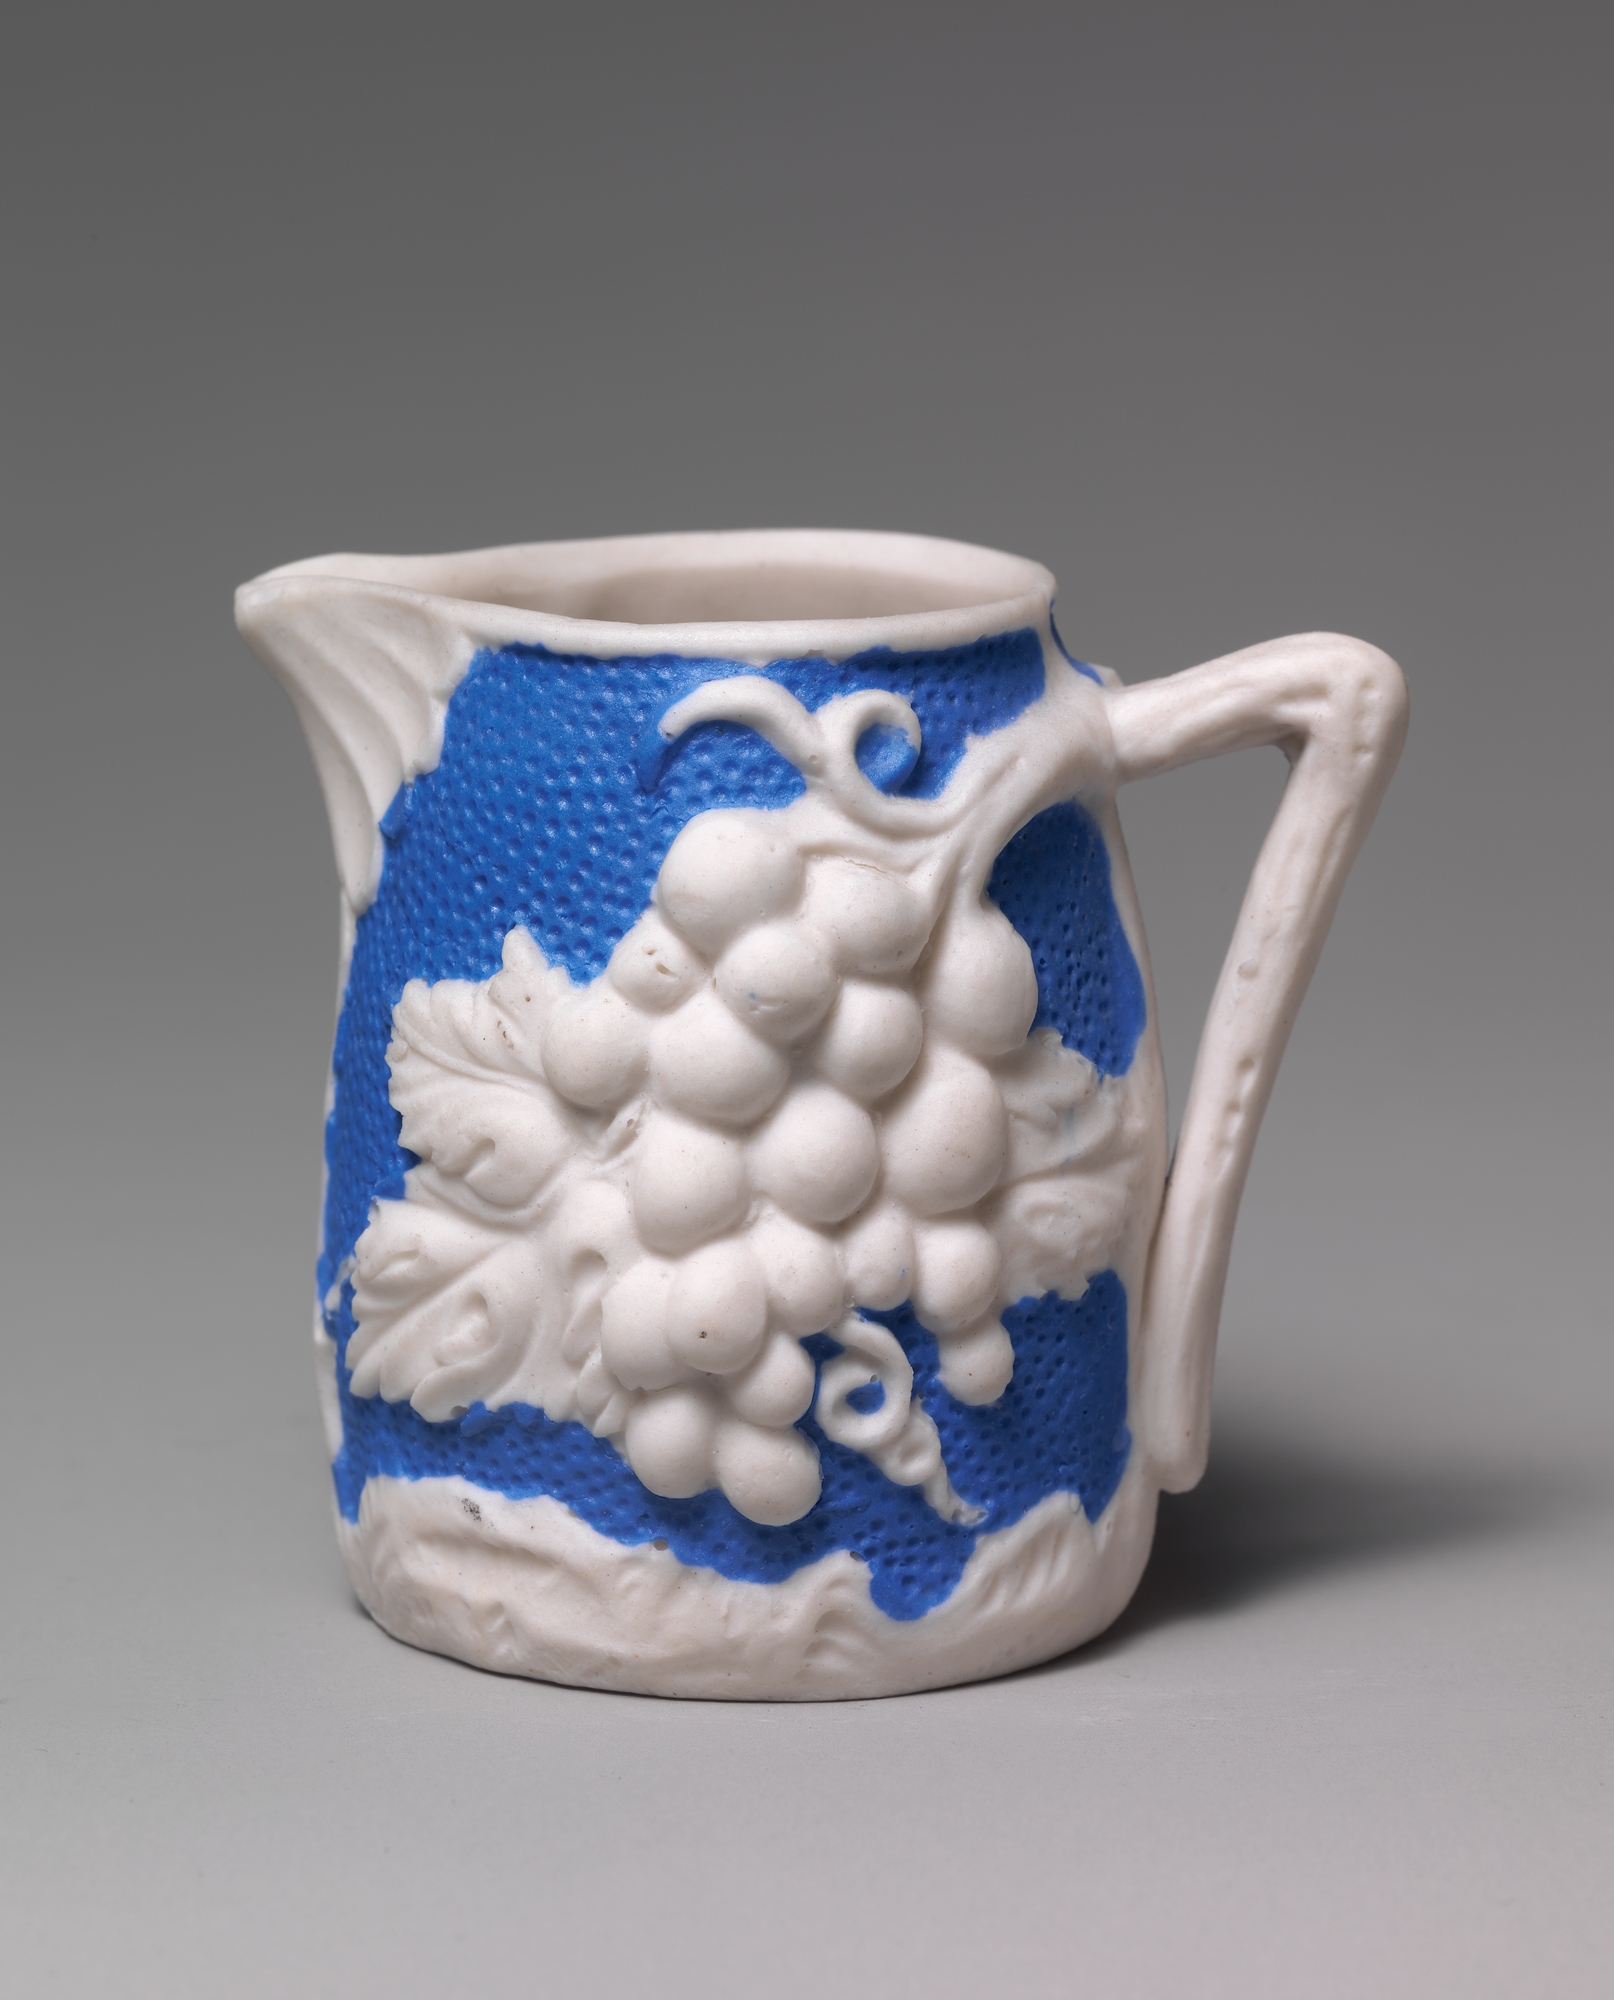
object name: pitcher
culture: american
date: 1830-1870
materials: porcelain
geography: united states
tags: grapes